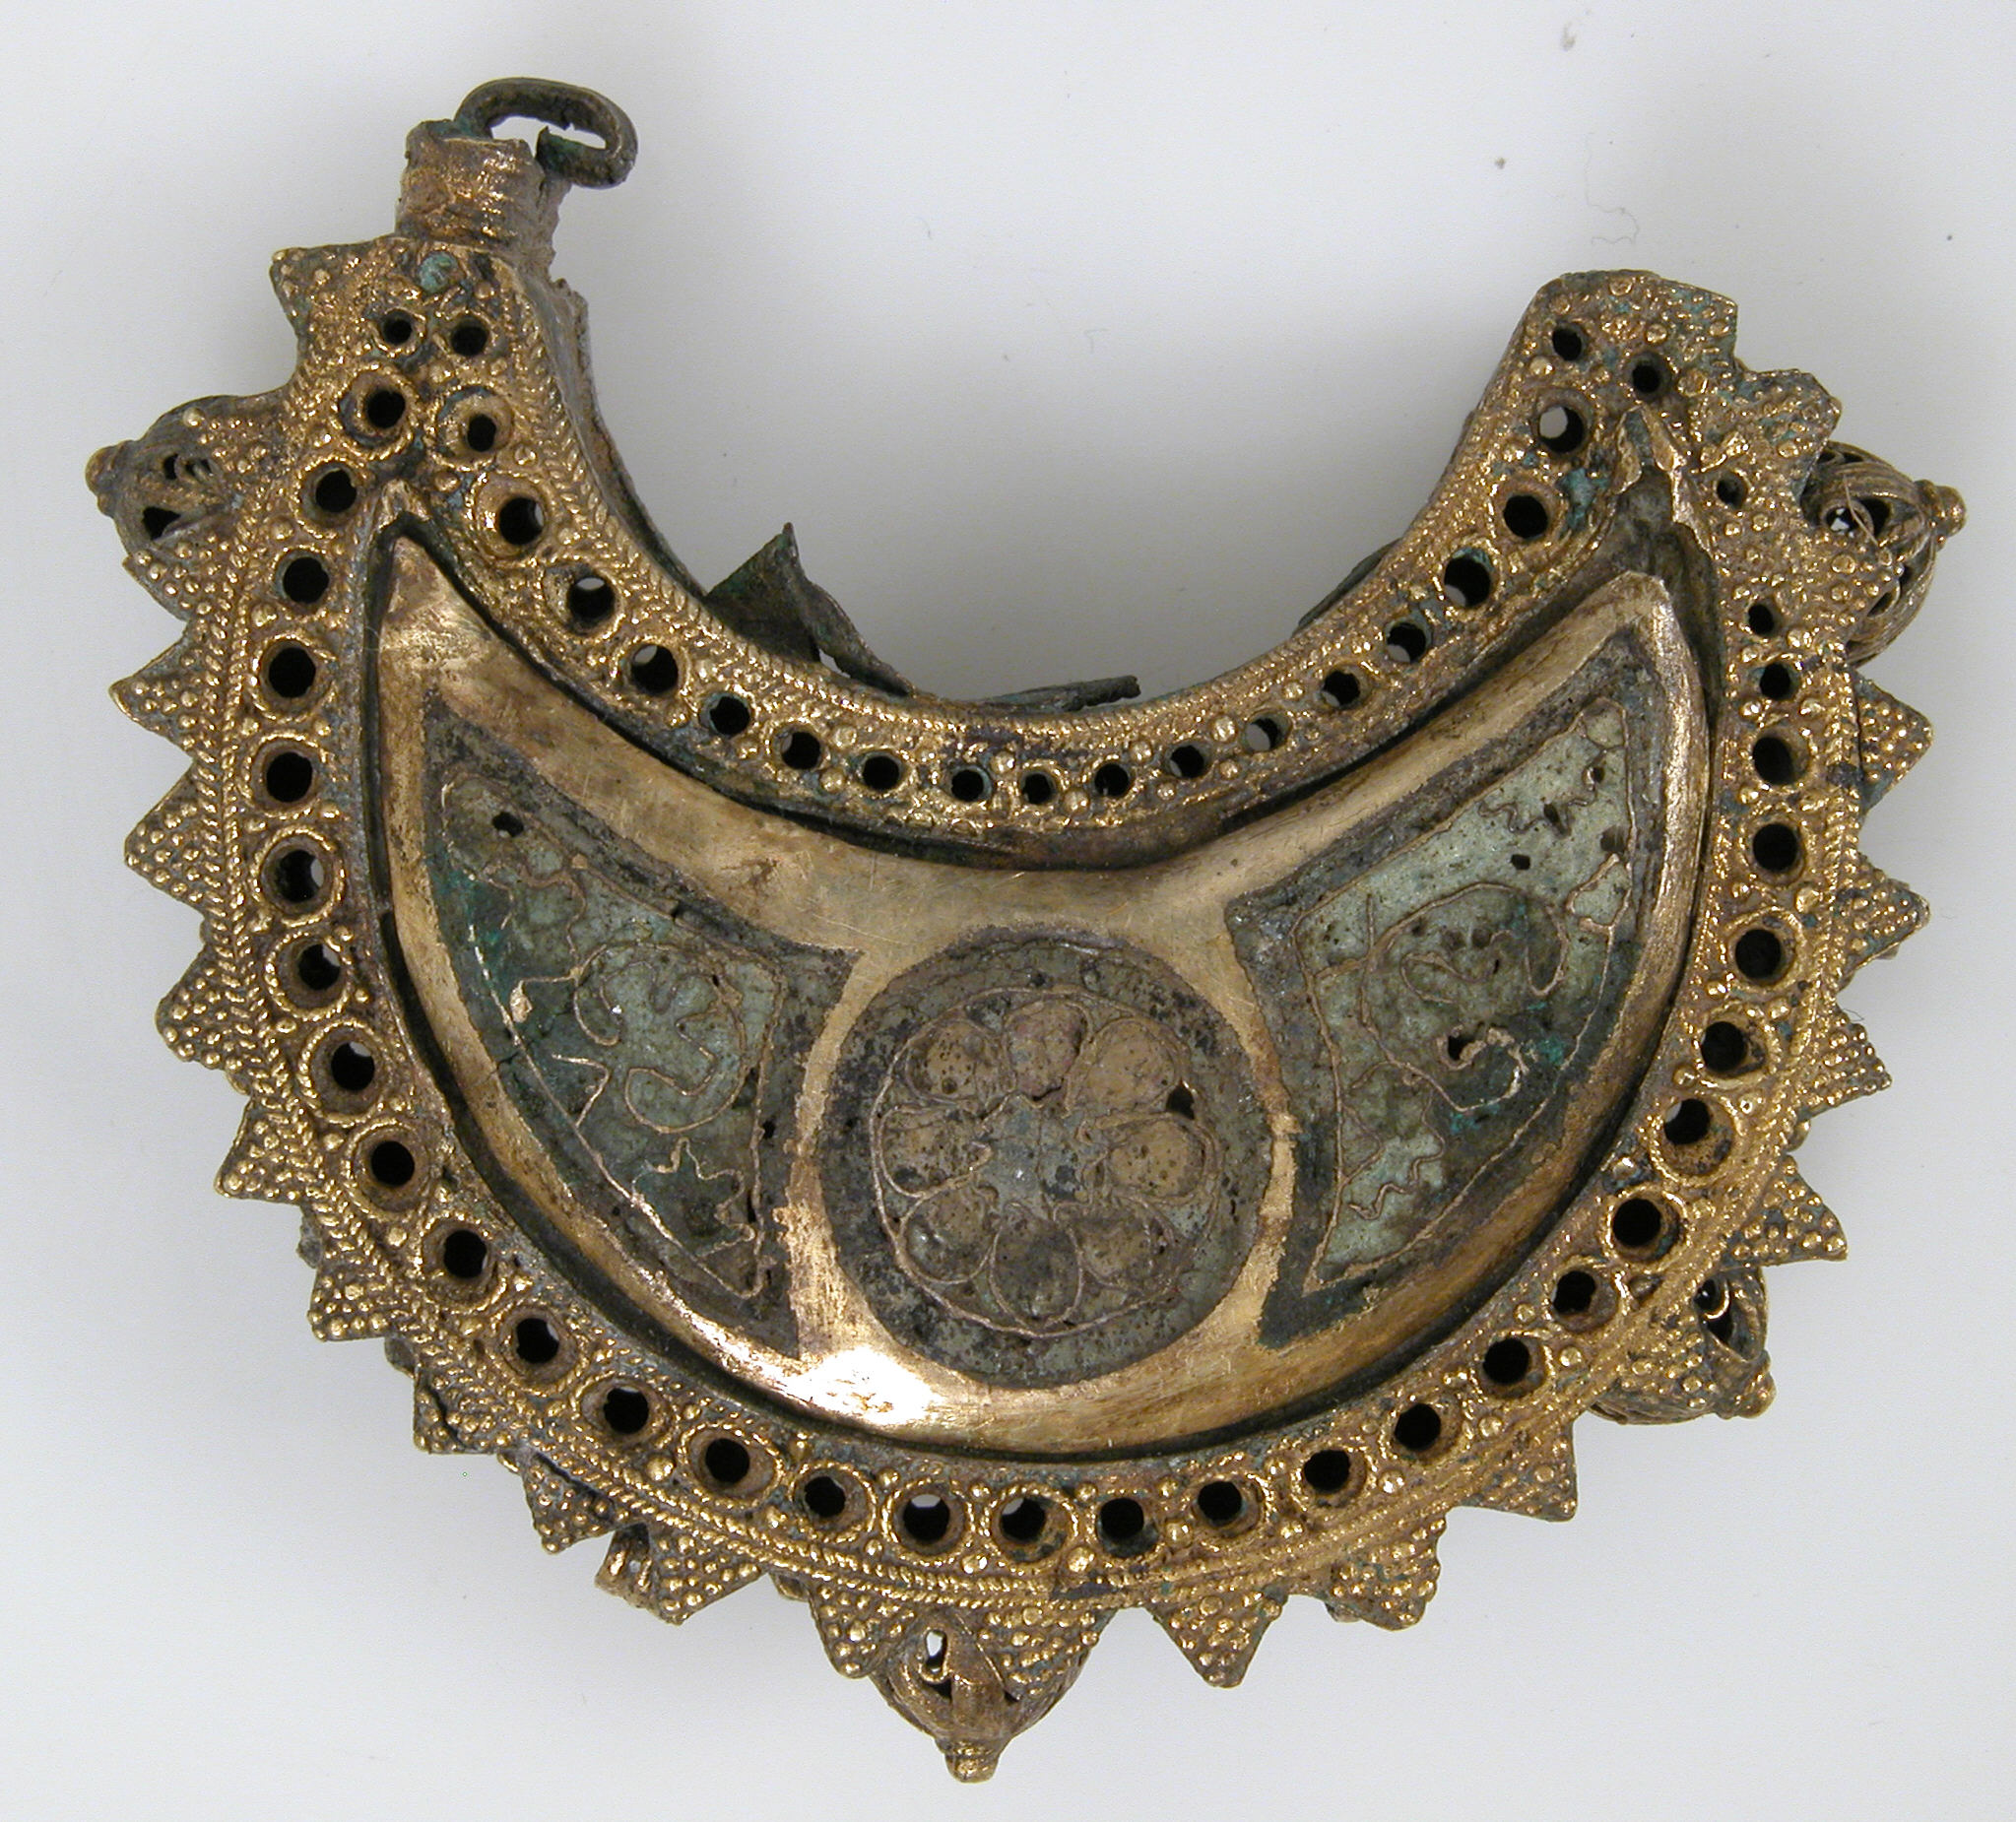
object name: earring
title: One of a Pair of Crescent-Shaped Earrings with Rosettes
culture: byzantine or kyivan rus'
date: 1101-1200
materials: enamel, silver gilt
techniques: enamel